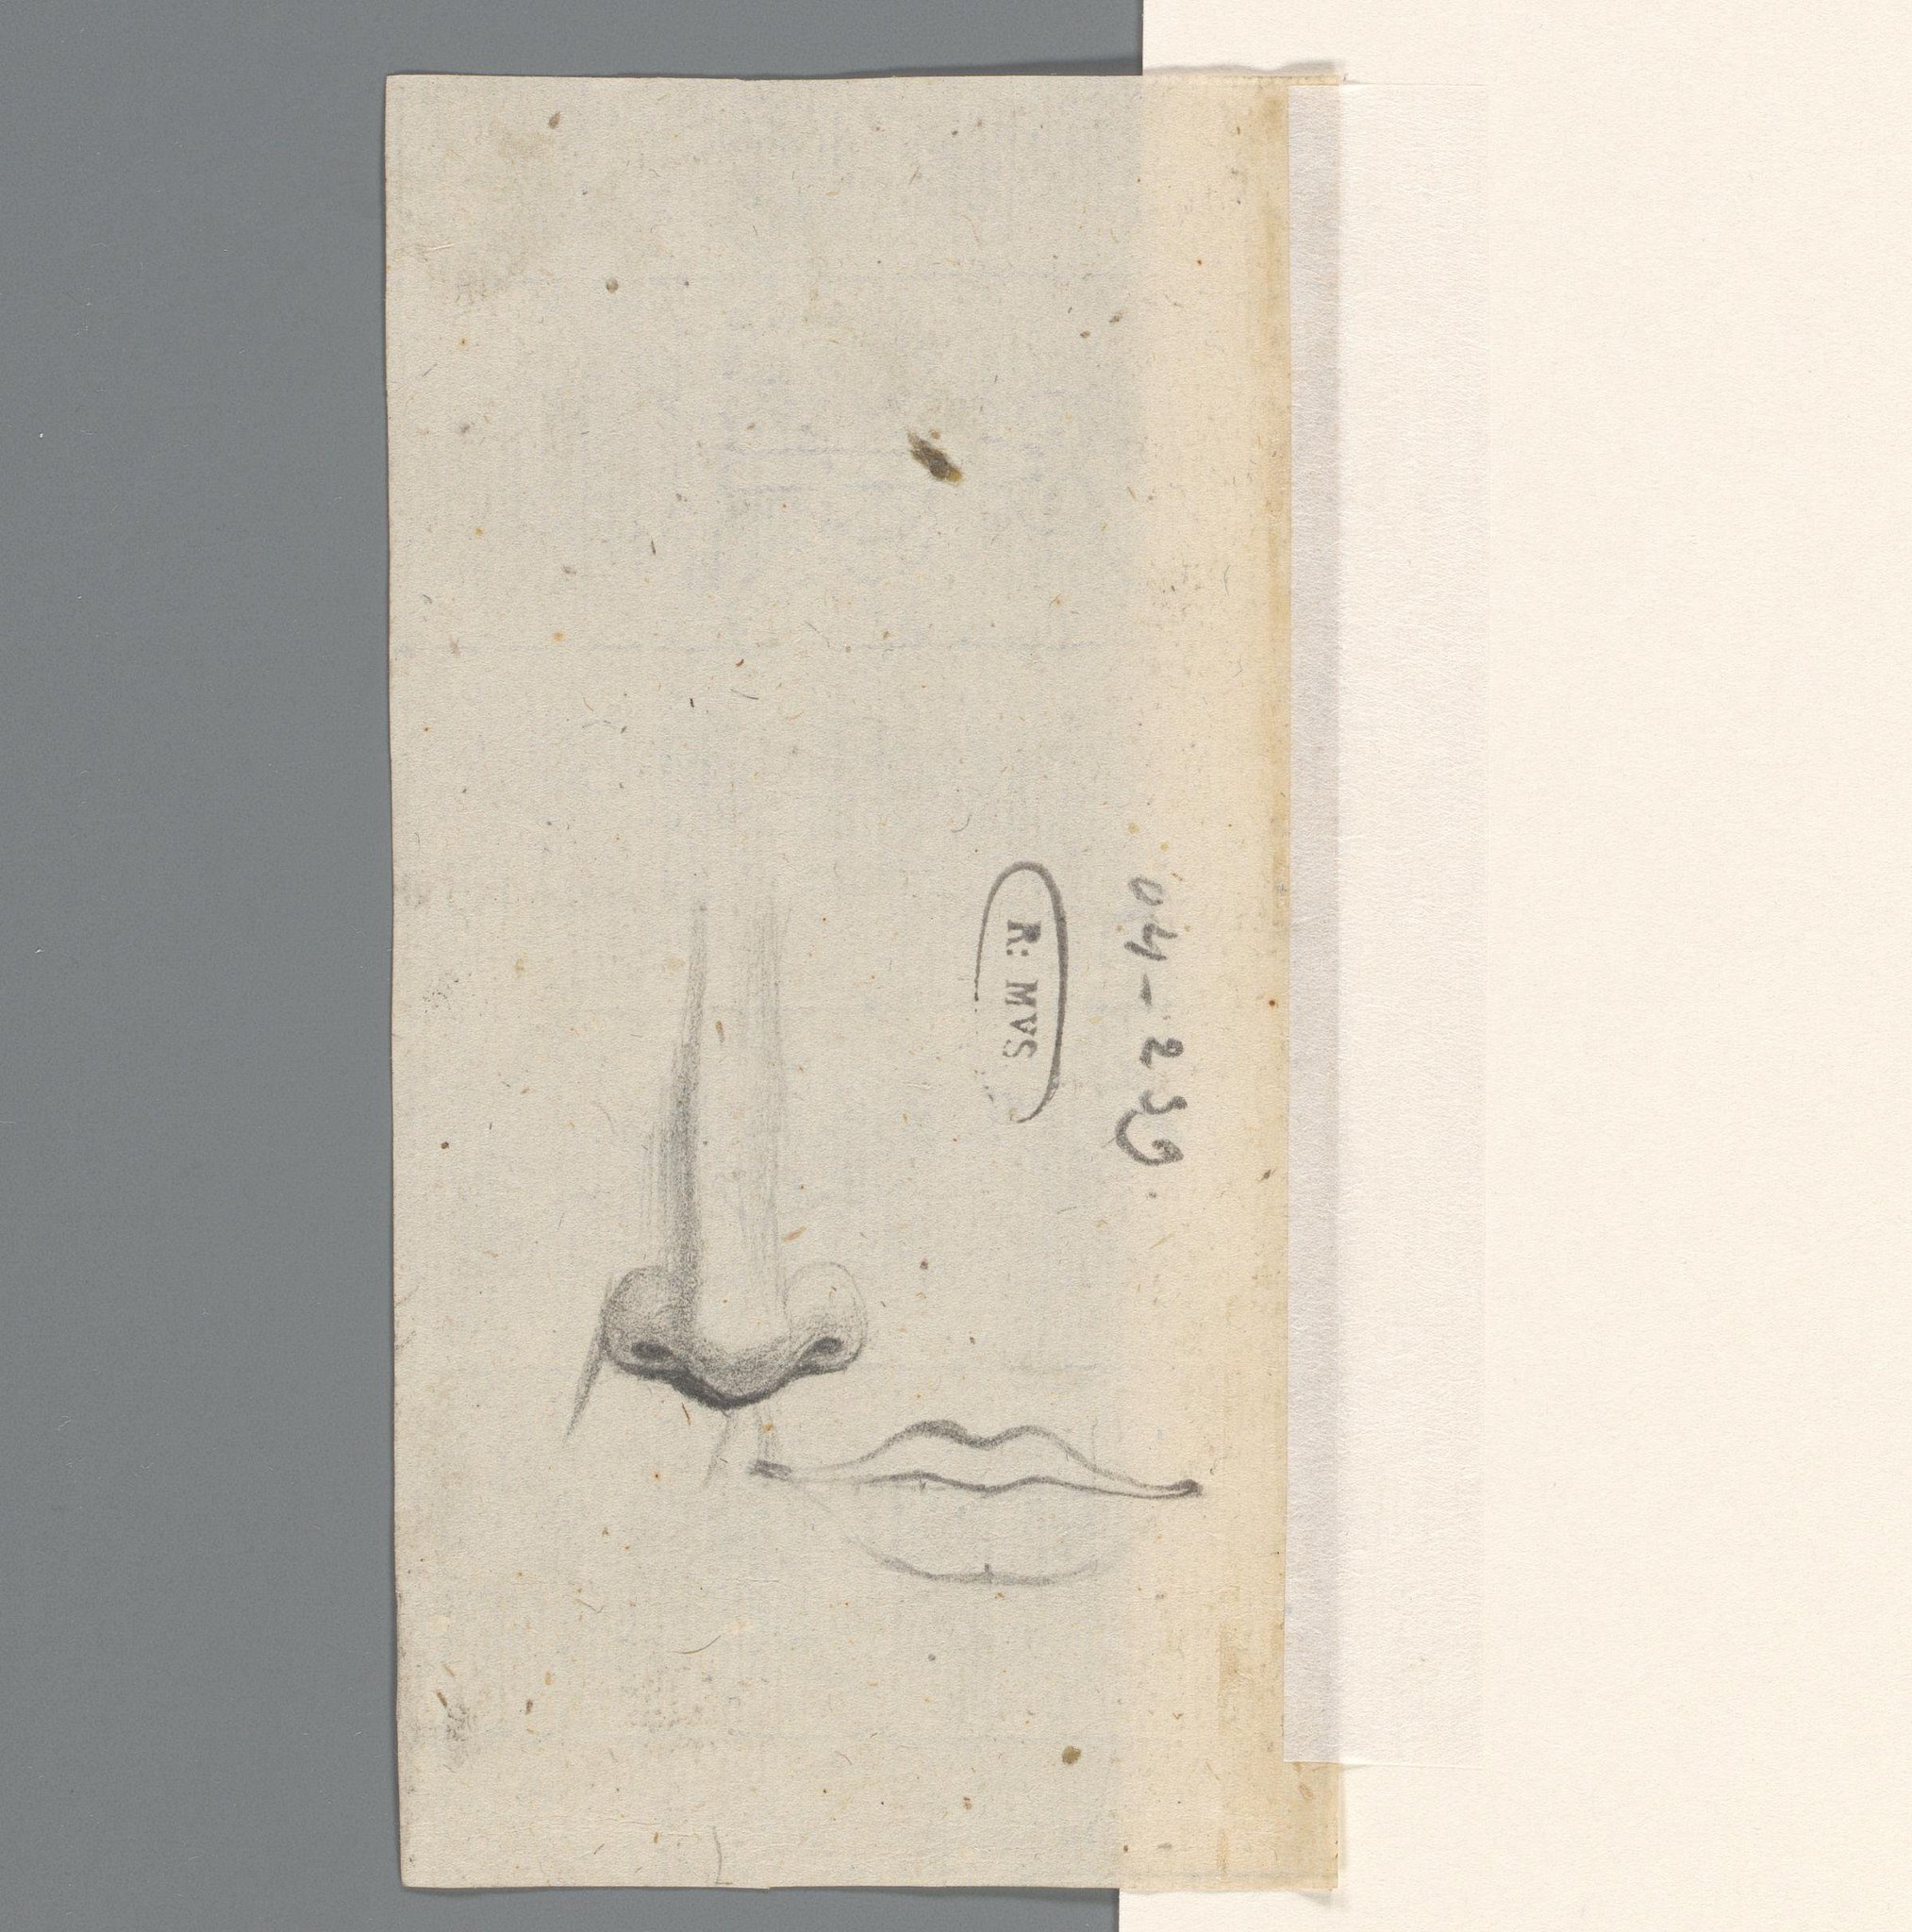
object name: drawing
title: Schetsen van een neus en mond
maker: jean bernard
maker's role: draughtsman, print maker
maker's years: 1765-1833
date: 1816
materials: chalk, paper, pencil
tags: parts of the face: nose, mouth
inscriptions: date: ‘1816’